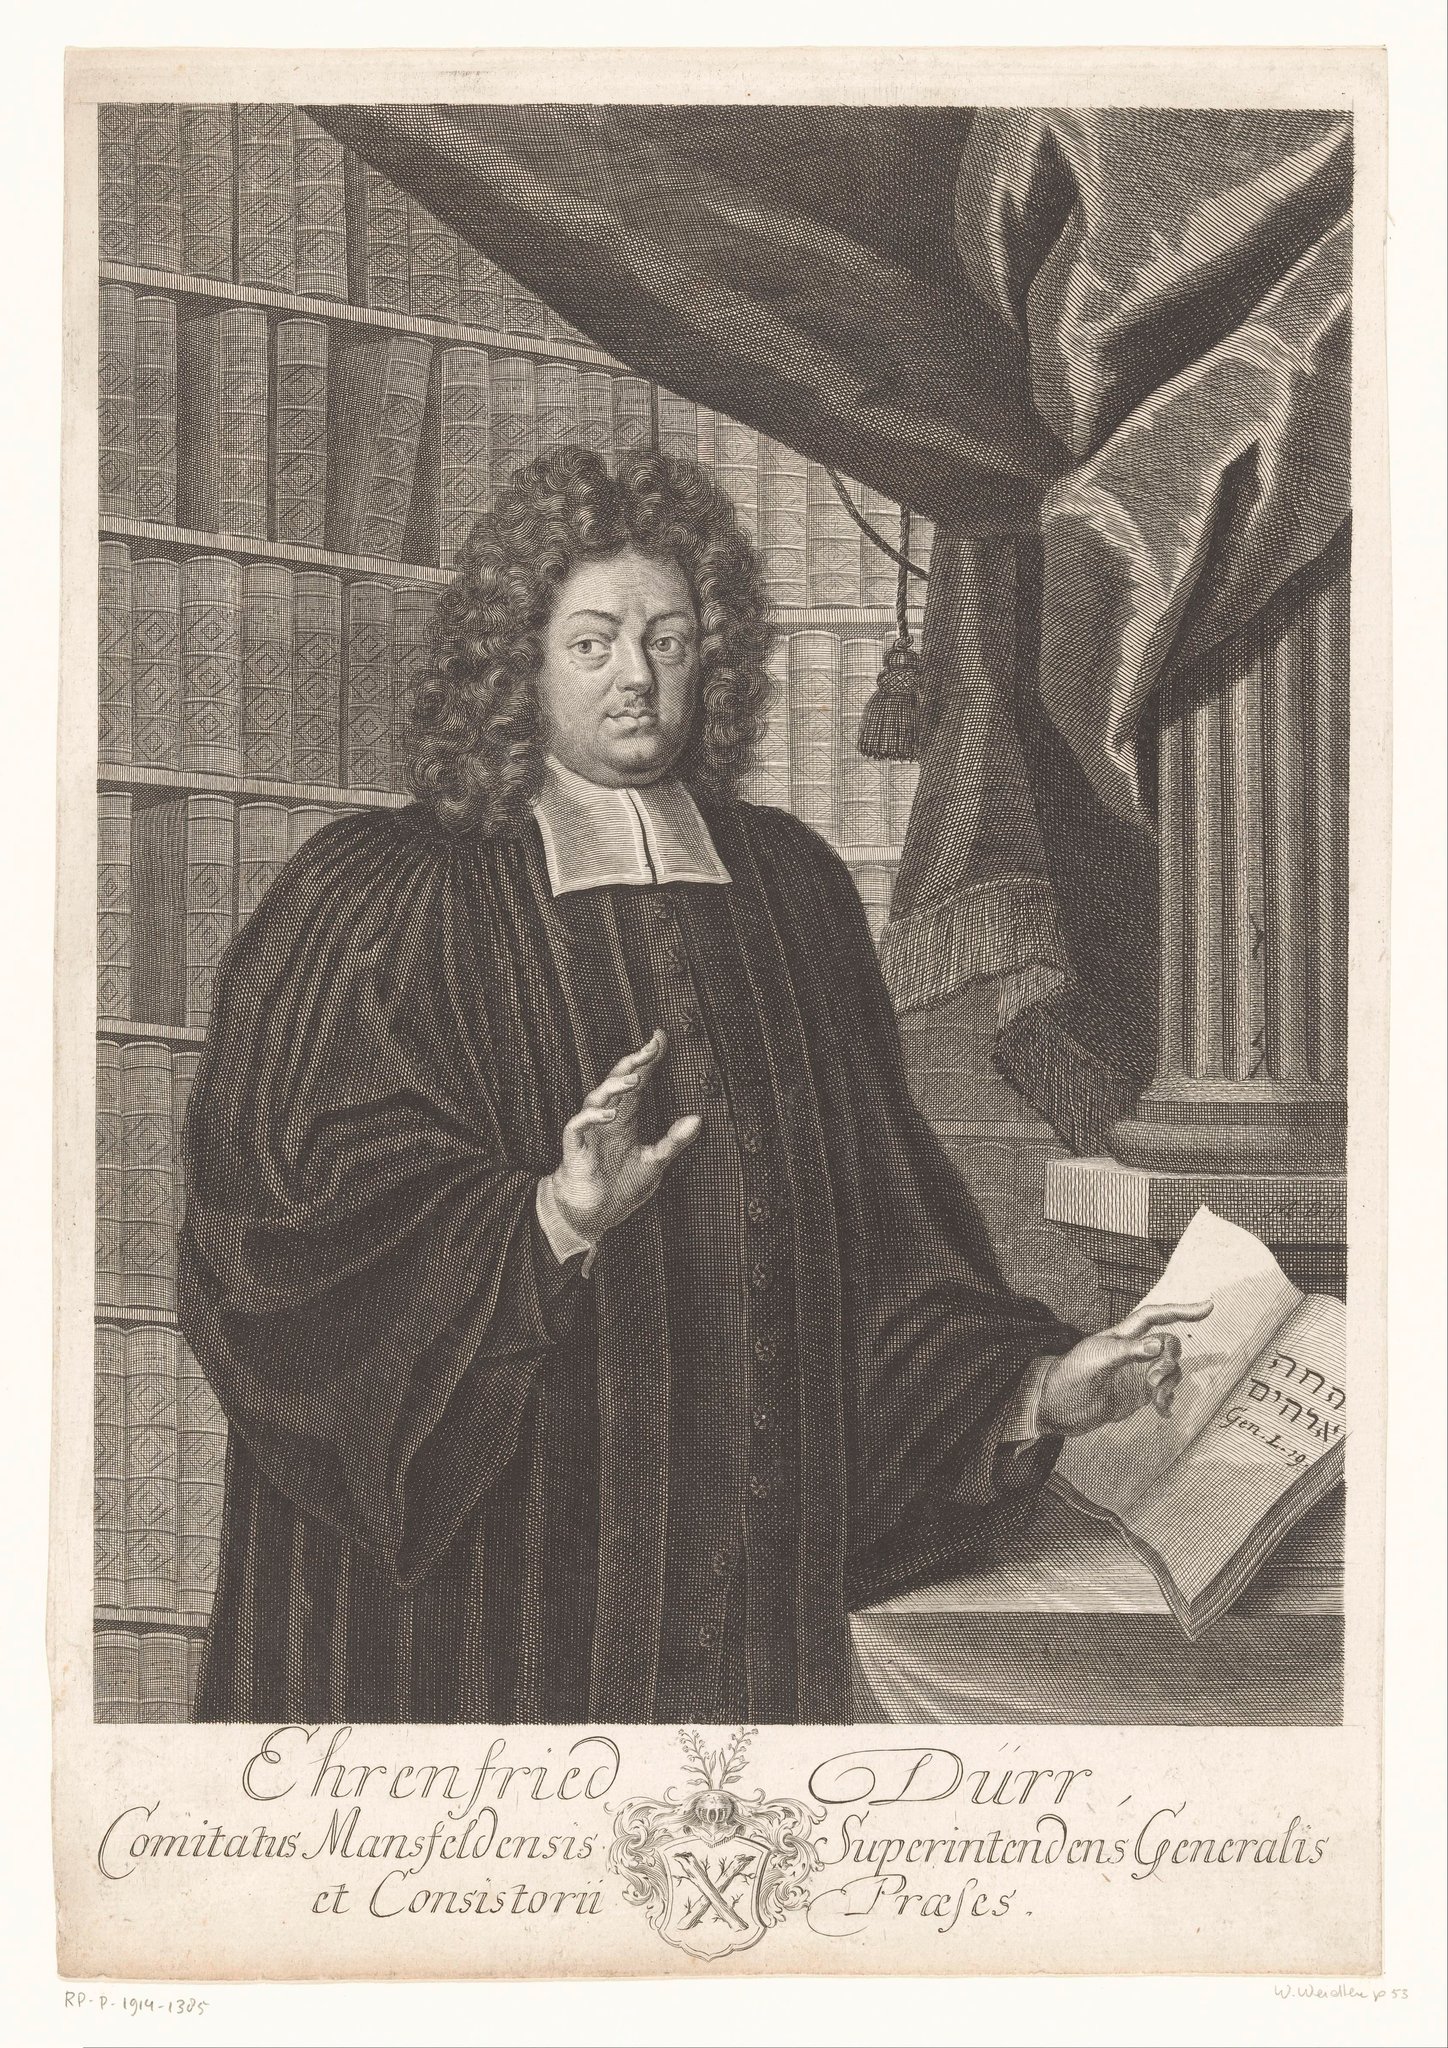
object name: print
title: Portret van Ehrenfried Dürr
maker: martin bernigeroth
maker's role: print maker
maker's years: 1670-1733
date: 1680-1733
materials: paper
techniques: engraving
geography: leipzig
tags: bookshelves, historical persons, book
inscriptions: collector's mark: Lugt 2228